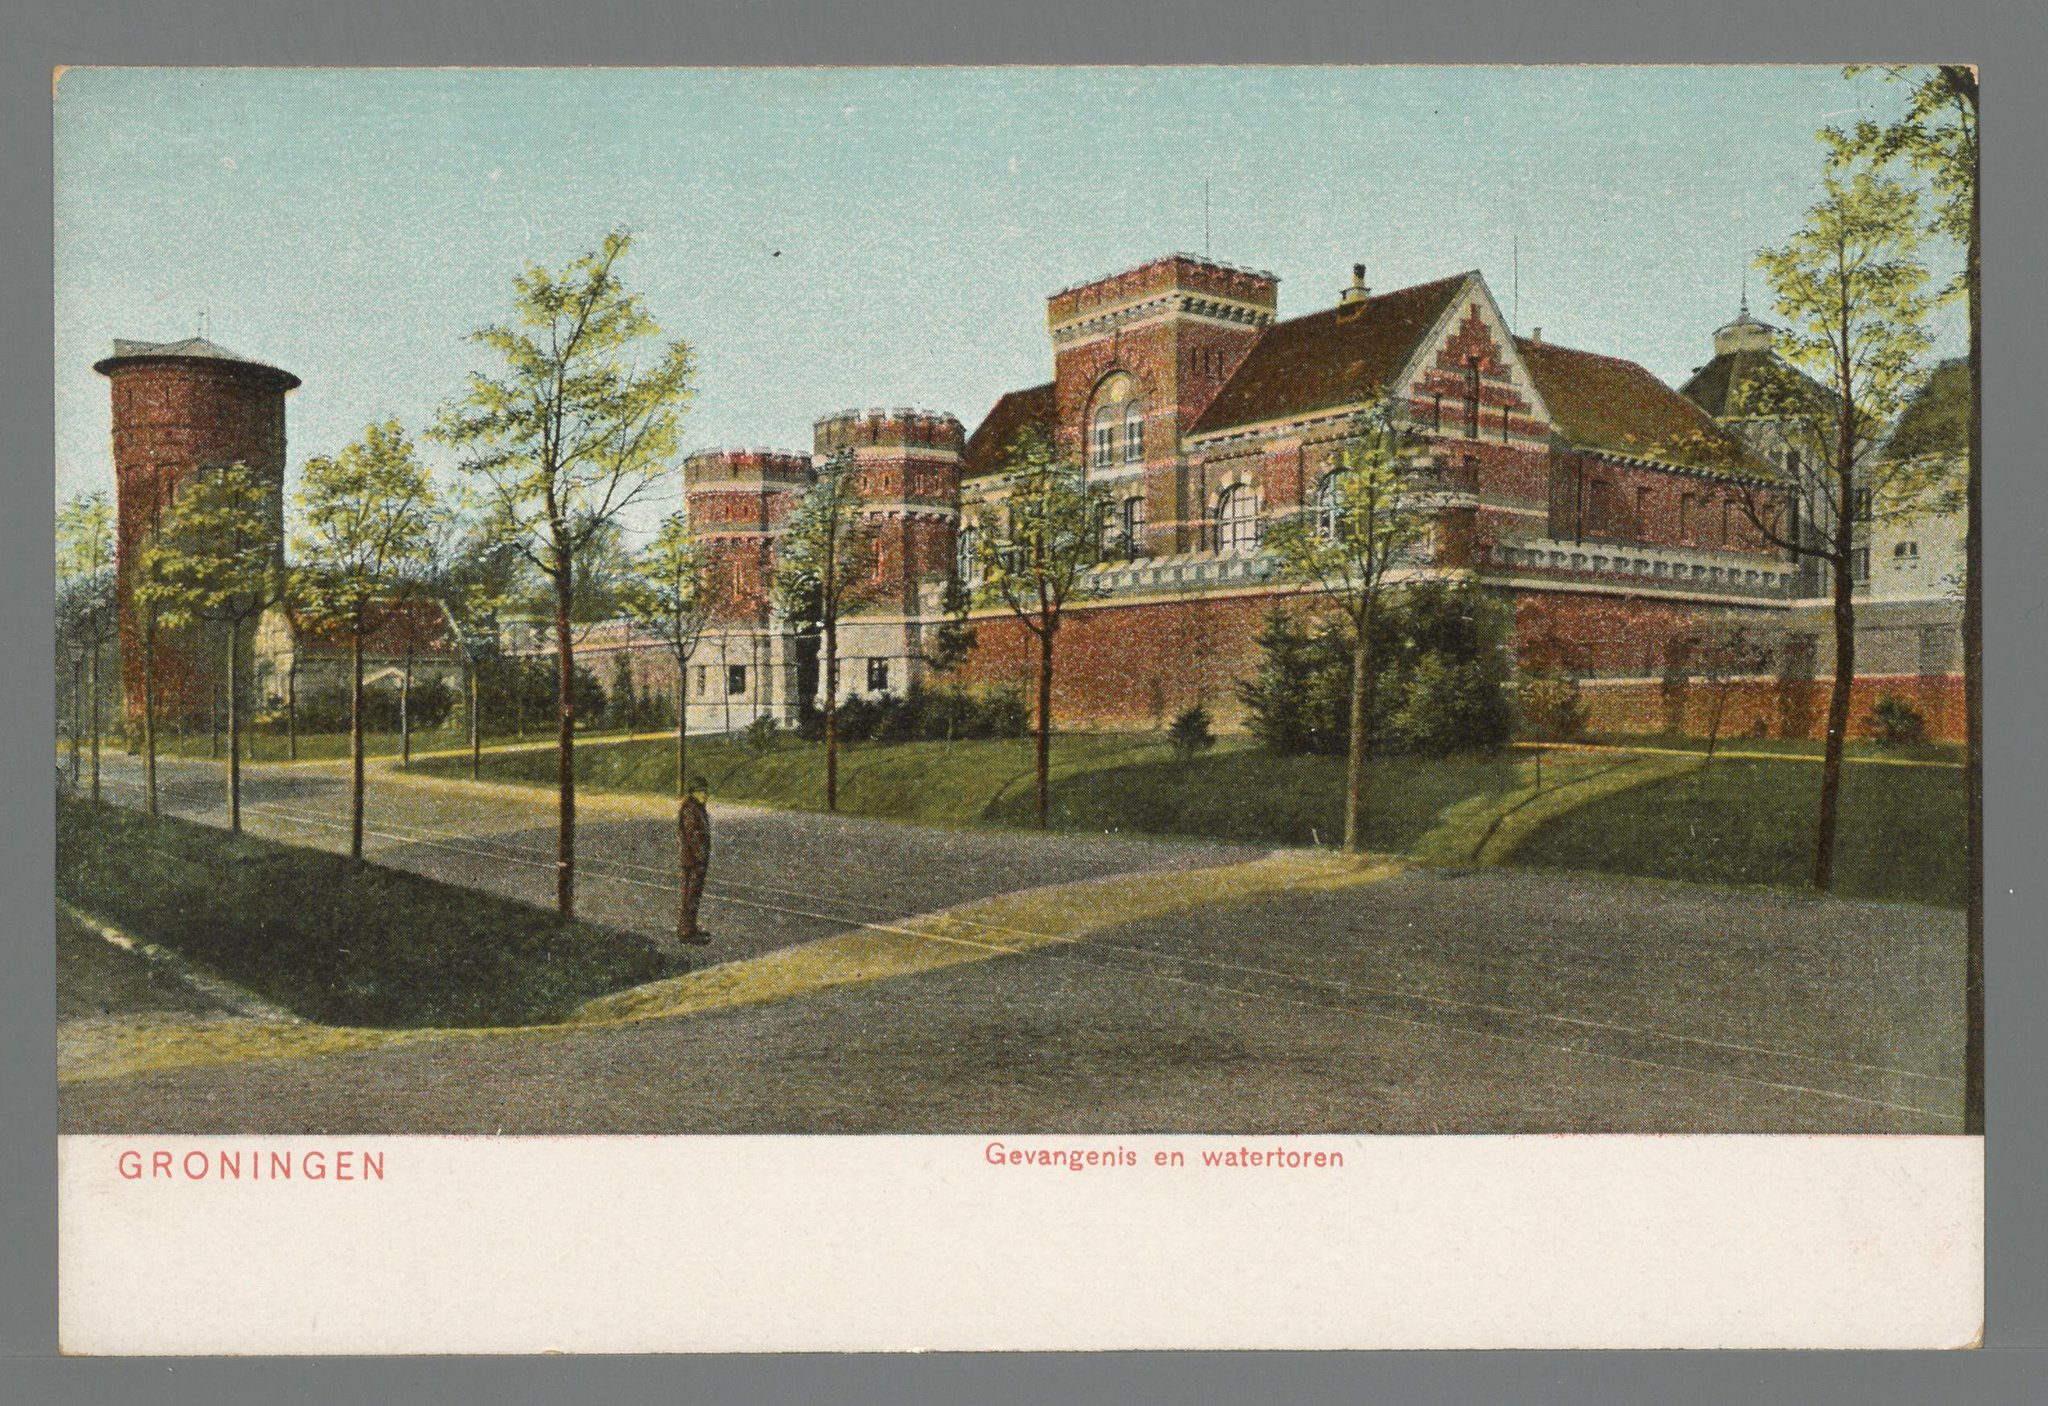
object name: ansichtkaart, prentbriefkaart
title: Groningen. Gevangenis en watertoren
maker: Anonymous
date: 1905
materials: cardboard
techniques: lithograph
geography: leipzig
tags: prison, jail, water tower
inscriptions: date